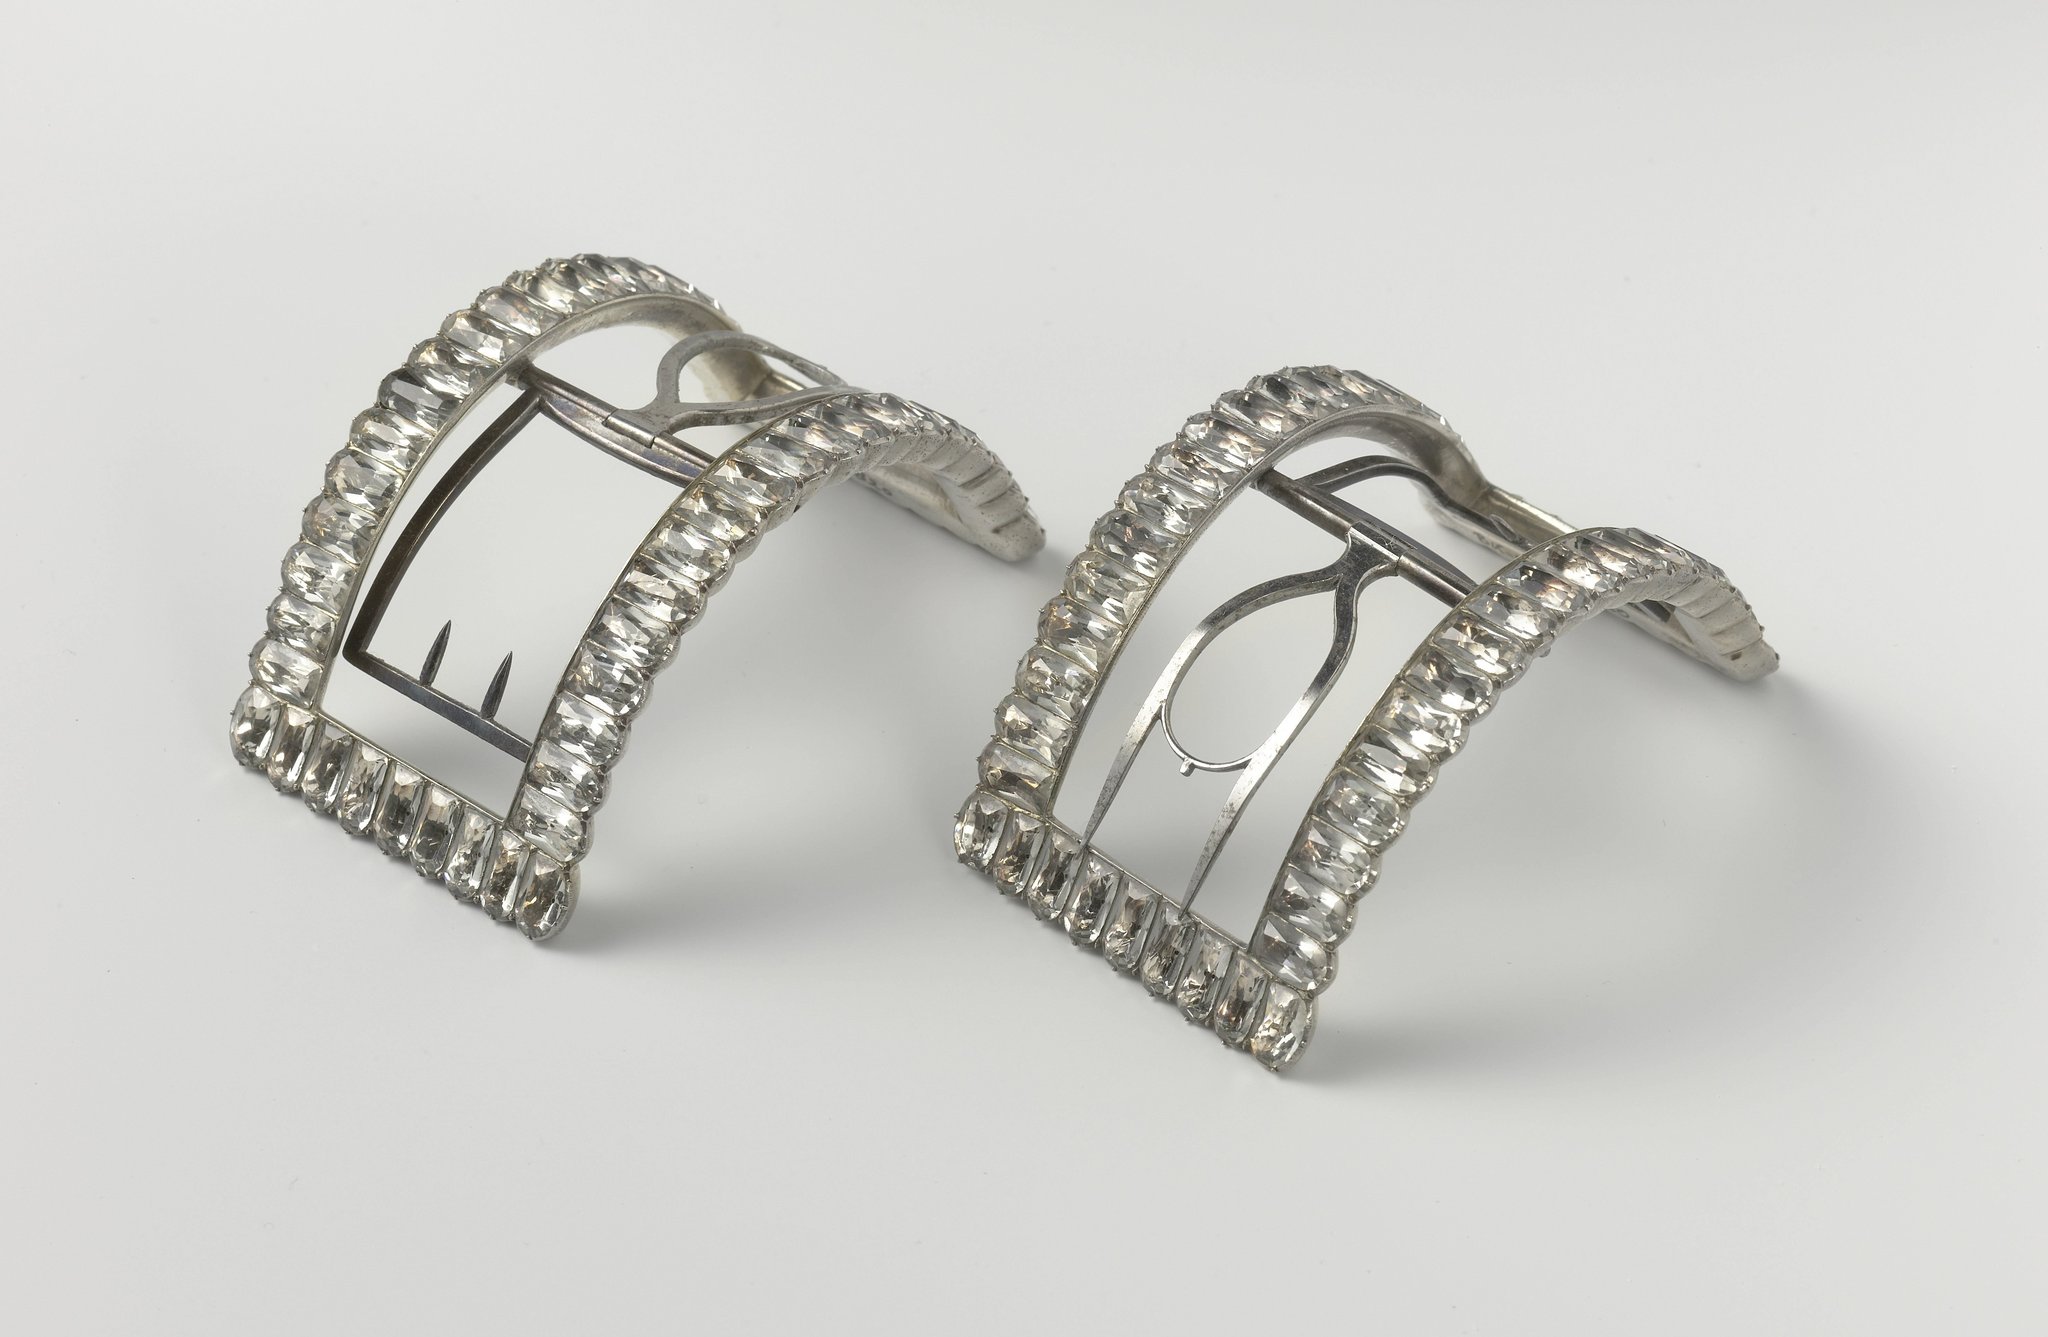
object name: jewellery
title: Shoe Buckles with Case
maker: Anonymous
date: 1775-1800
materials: cardboard, paste, silk, silver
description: Men’s shoes in the 18th century were quite plain in both shape and material. However, they could be decorated with buckles like these, which are made of silver and set with rhinestones. They even have their own pouch, suggesting they were used on special occasions, rather than every day.